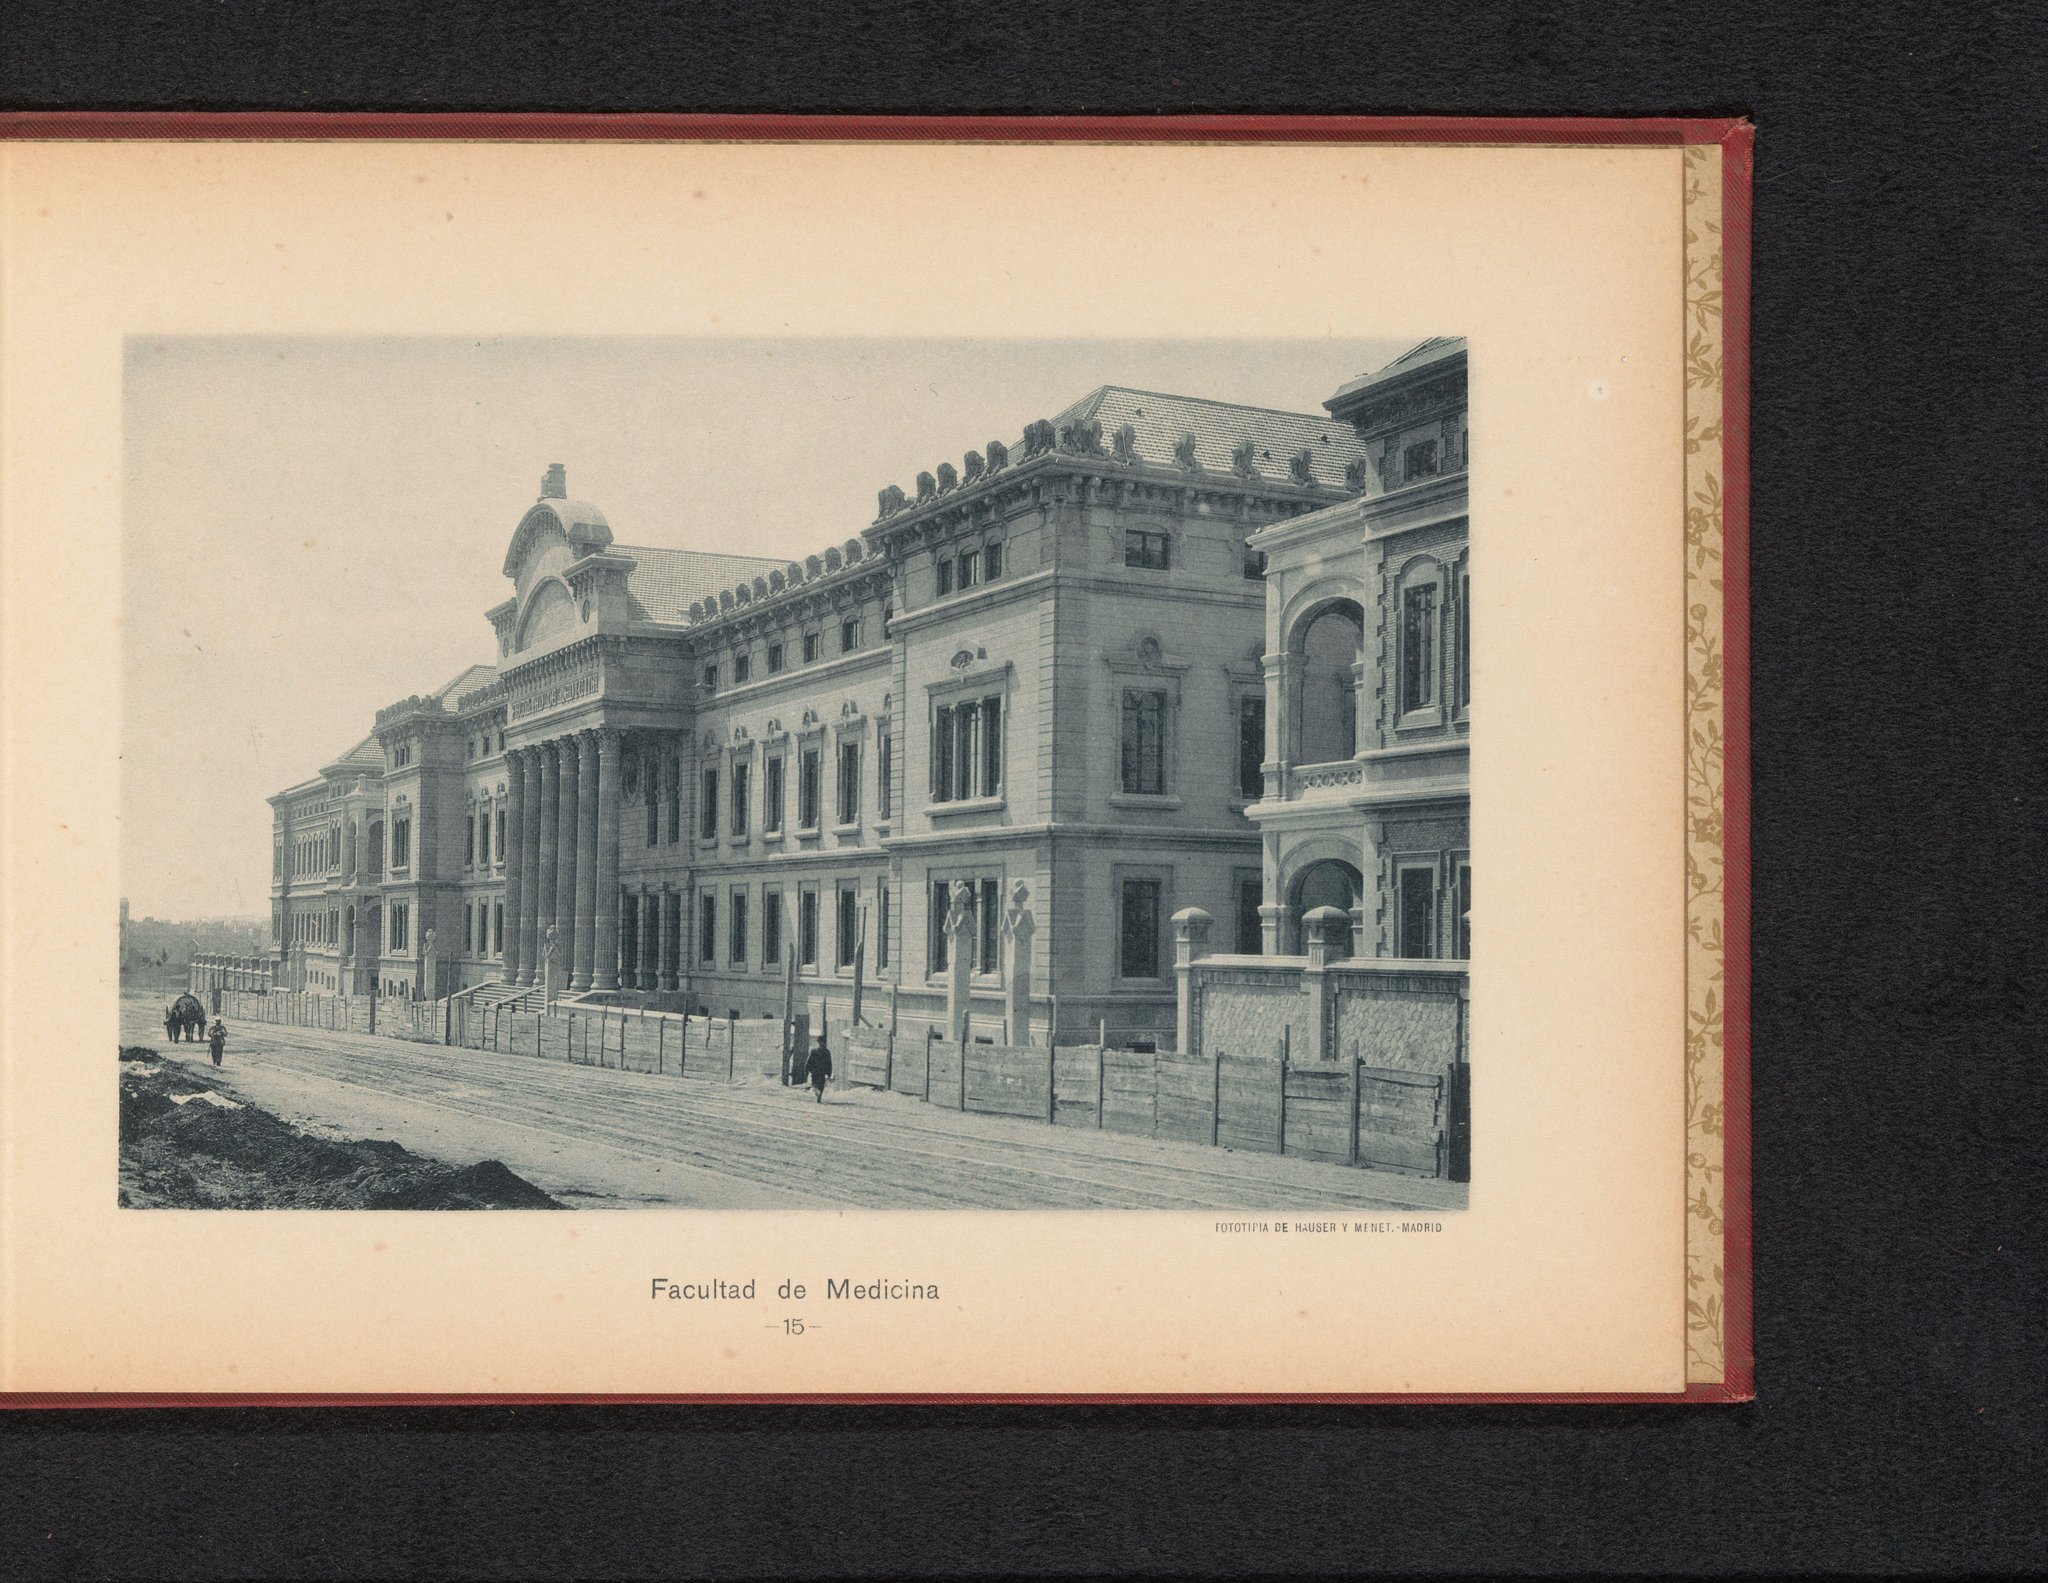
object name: page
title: Facultad de Medicina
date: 1880-1890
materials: paper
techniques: photograph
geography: barcelona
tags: university building, college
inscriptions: number: ‘-15-’